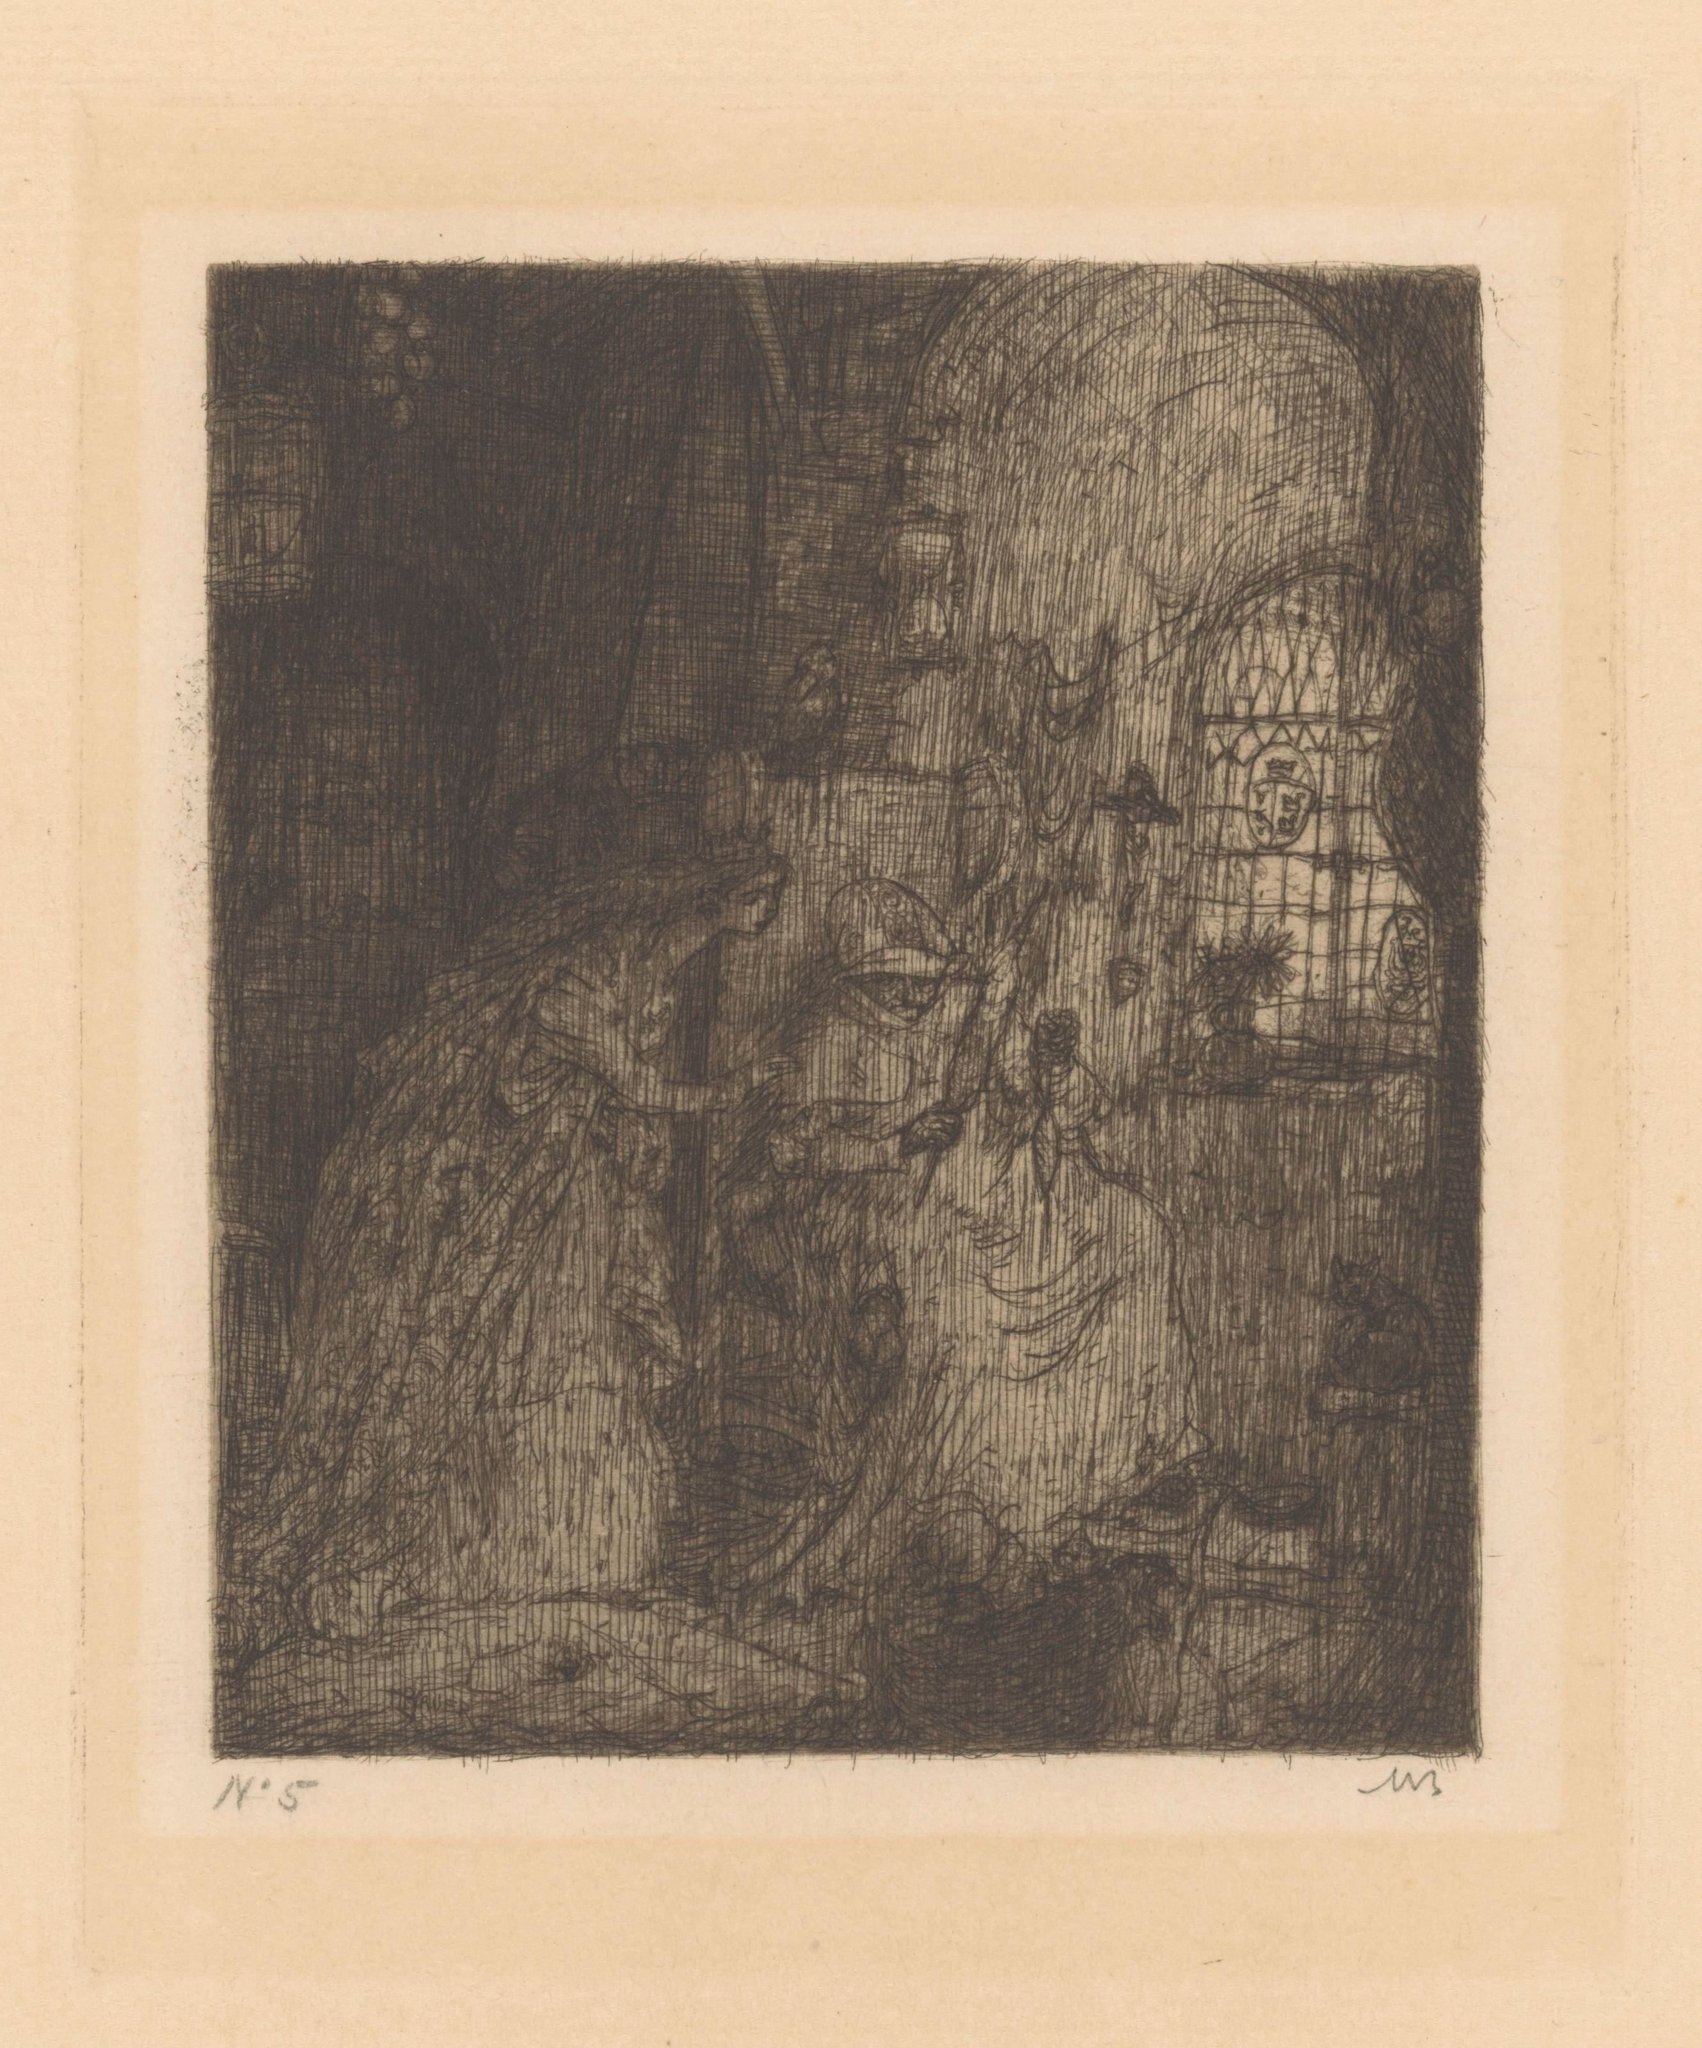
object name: print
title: De schone slaapster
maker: marius bauer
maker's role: draughtsman, print maker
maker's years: 1867-1932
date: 1894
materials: paper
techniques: etching, intaglio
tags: tales and fairy tales: sleeping beauty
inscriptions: collector's mark: Lugt 2521a, collector's mark: Lugt 2228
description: Een prinses, beter bekend als Doornroosje, staat naast een oude vrouw met een spintol die vlas zit te spinnen. Doornroosje valt honderd jaar in slaap nadat ze zich aan de spintol prikt, op grond van een vervloeking bij haar geboorte.